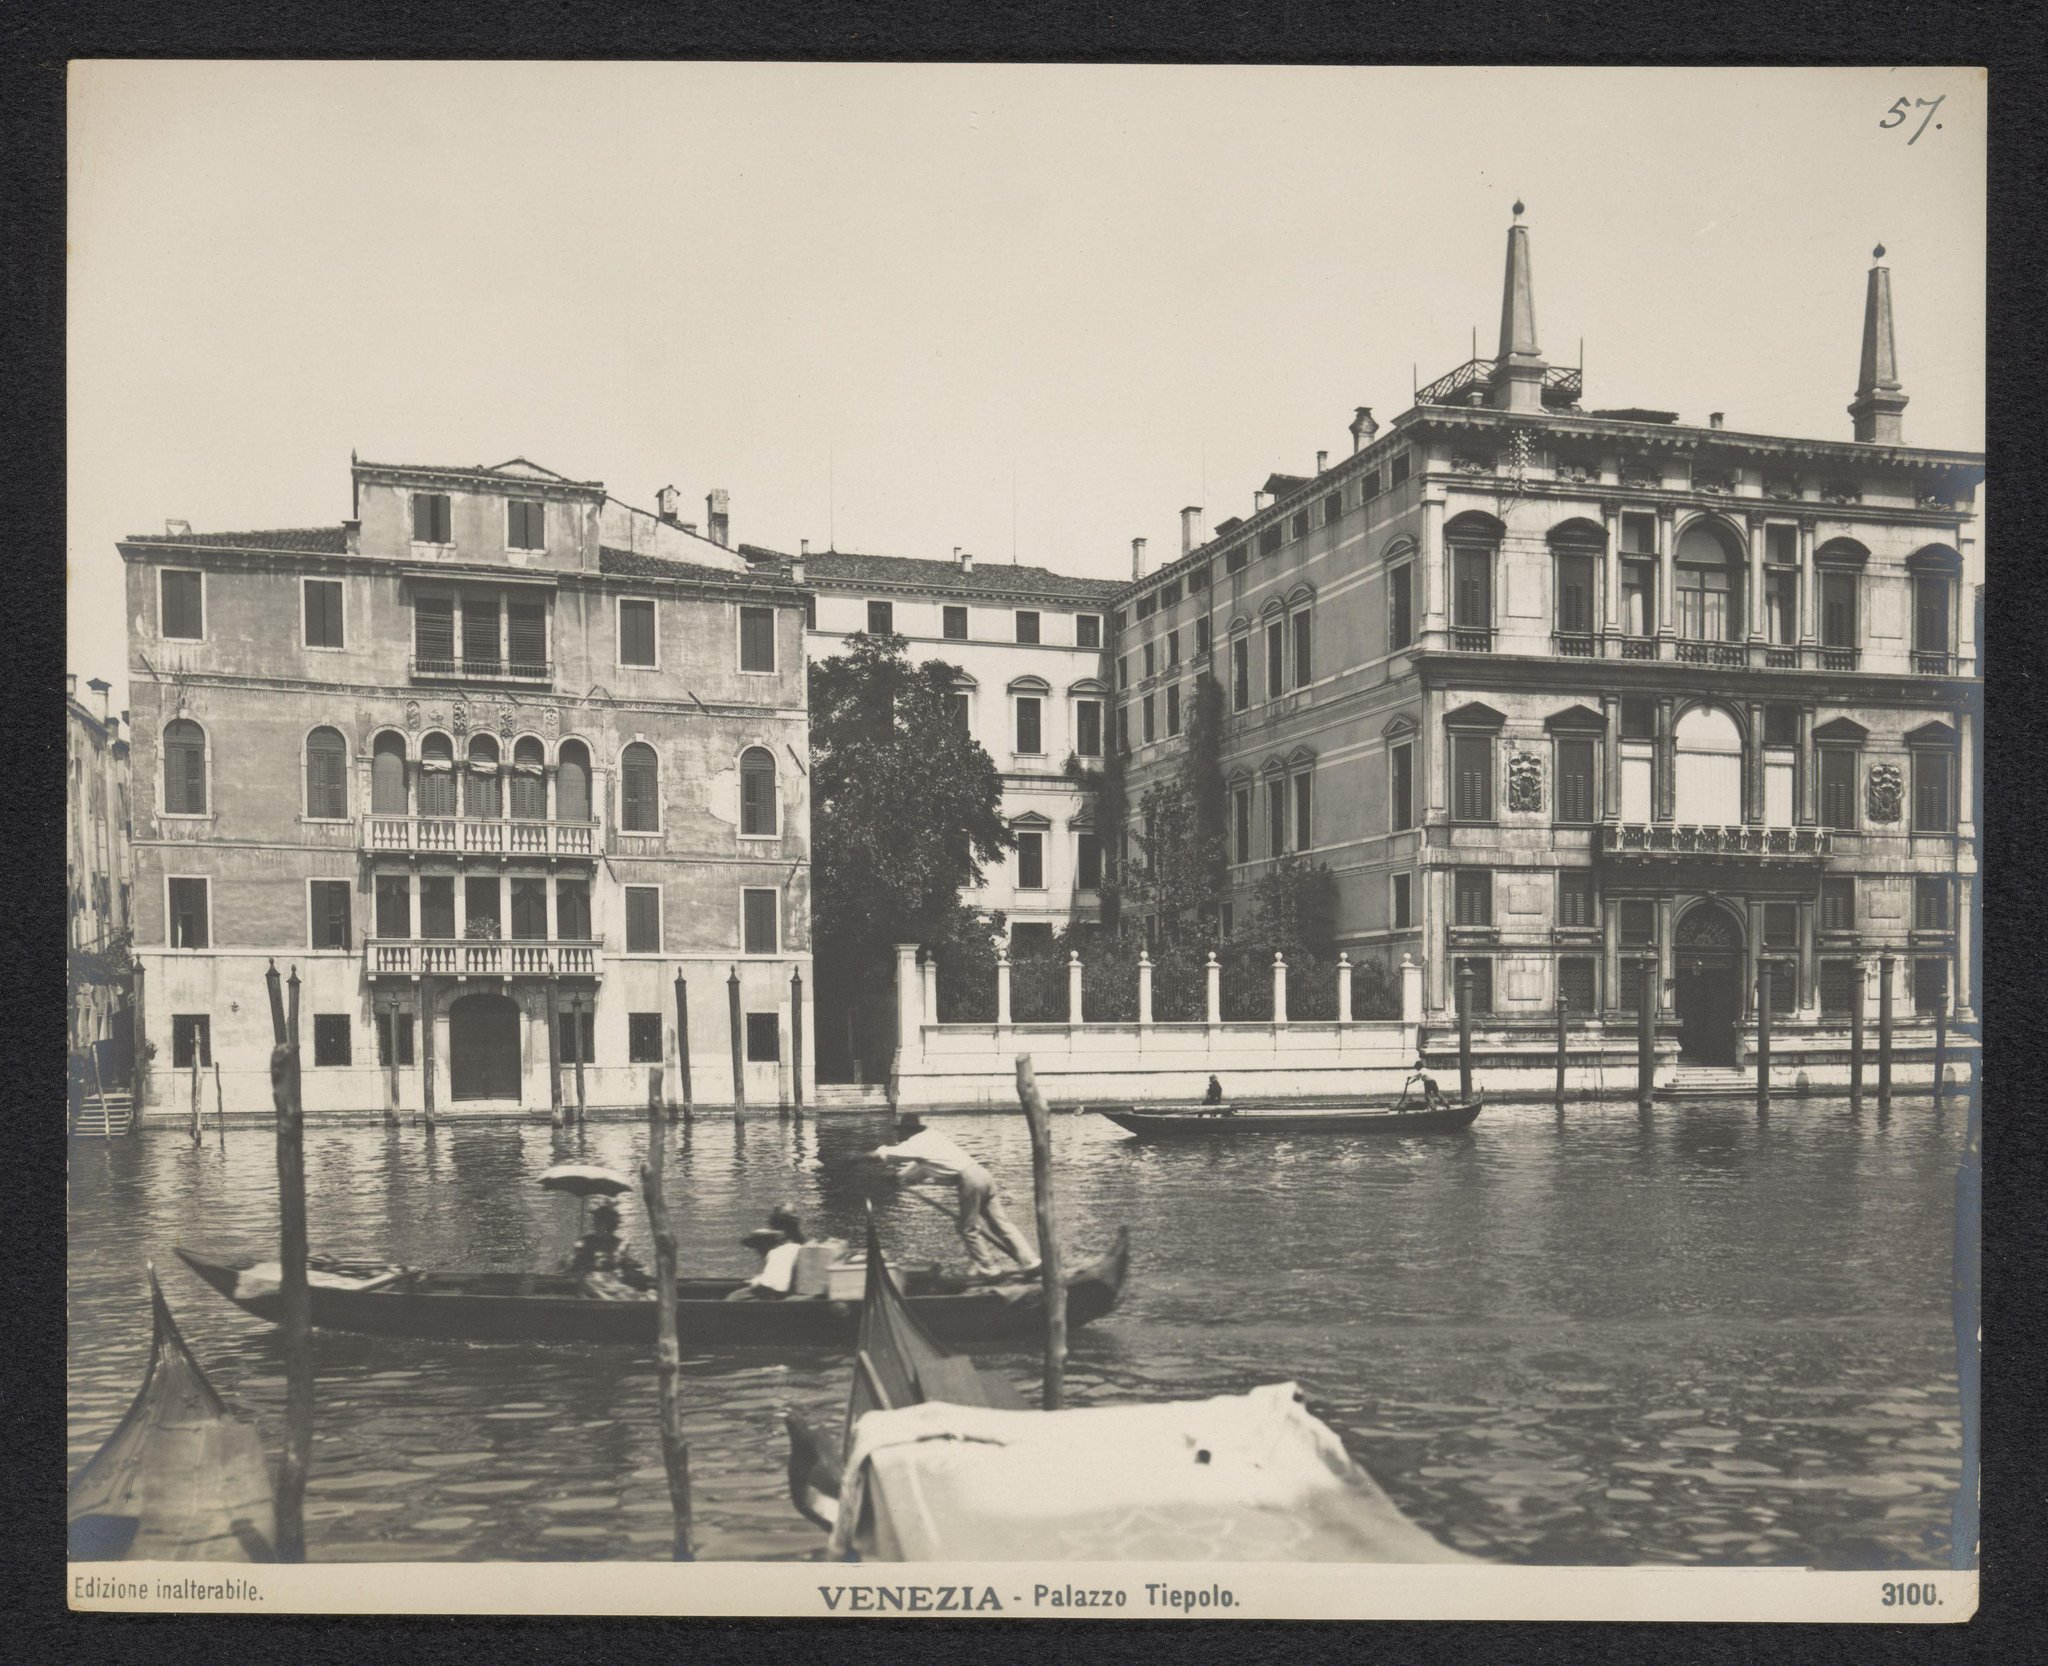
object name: photograph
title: Venezia - Palazzo Tiepolo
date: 1900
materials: cardboard, photographic support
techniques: gelatin silver print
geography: venice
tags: canal, hôtel, i.e. small palace in city, gondola, quay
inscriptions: number: ‘57.’, number: ‘3100.’